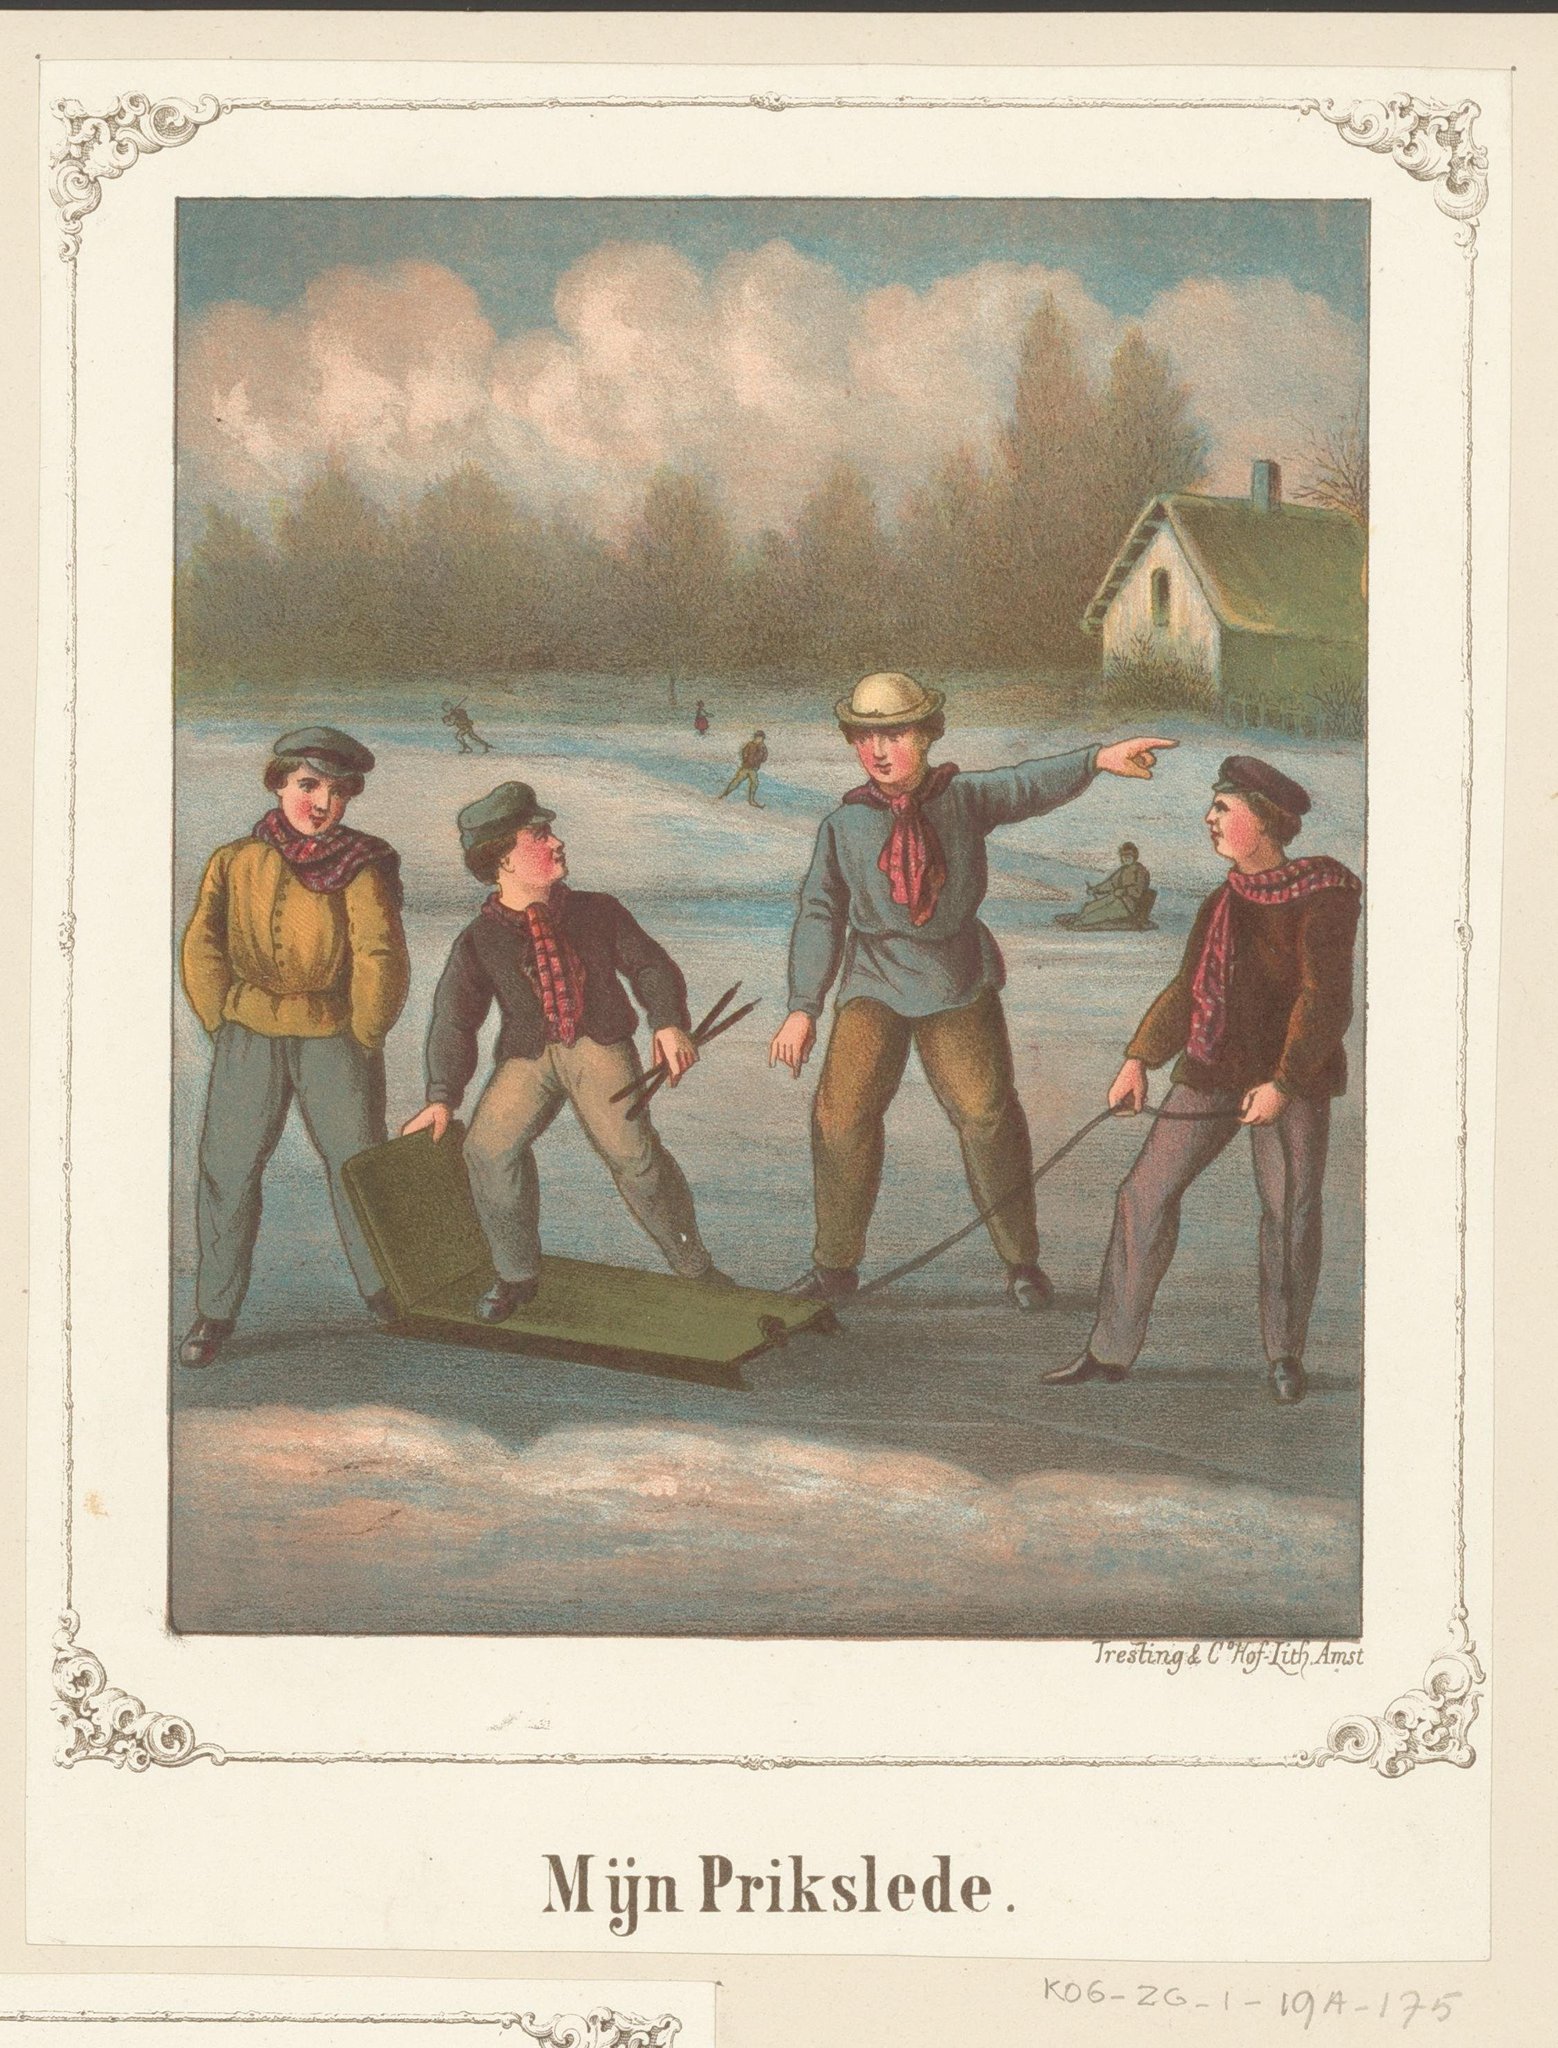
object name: print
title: Vier jongens spelen met een prikslee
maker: Anonymous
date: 1858-1919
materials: paper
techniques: lithograph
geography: amsterdam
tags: children's games and plays, snow, ice ~ state of water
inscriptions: stamp, collector's mark: Lugt 1641, stamp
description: Onderwerpsrubrieken binnen de Atlas Zeden en Gewoonten: Zeden en Gewoonten in Engeren Zin, Des menschen beging, midden en einde, Kinderleven – Kinderspel en Kinderprenten.